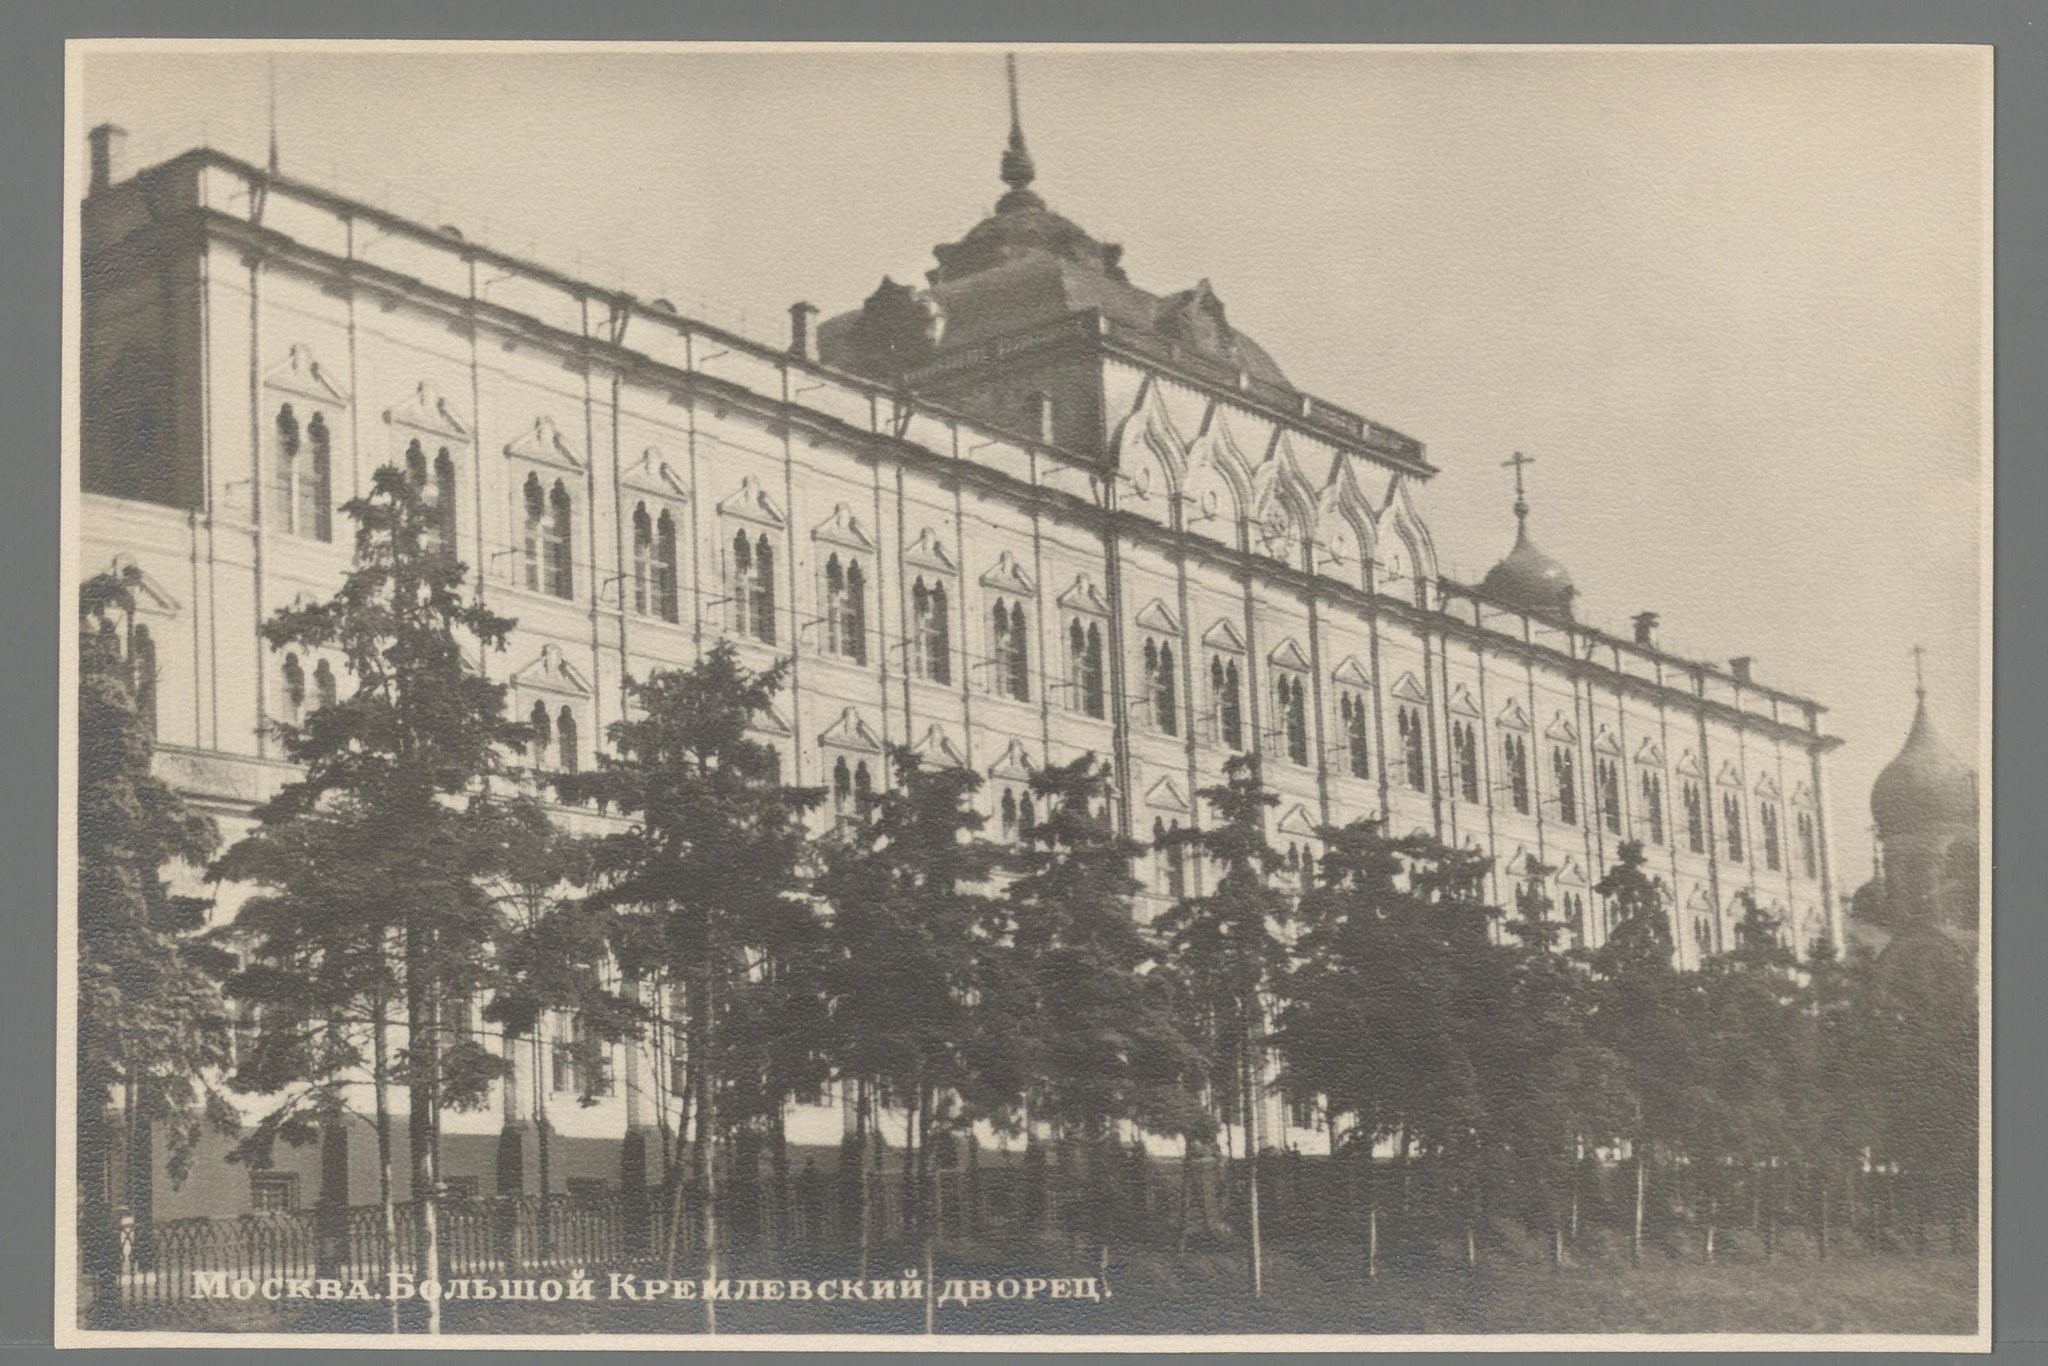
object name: ansichtkaart, prentbriefkaart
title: Gezicht op het Groot Paleis in het Kremlin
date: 1954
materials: paper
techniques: gelatin silver print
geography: moscow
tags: palace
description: De titel op object staat in het Russisch.